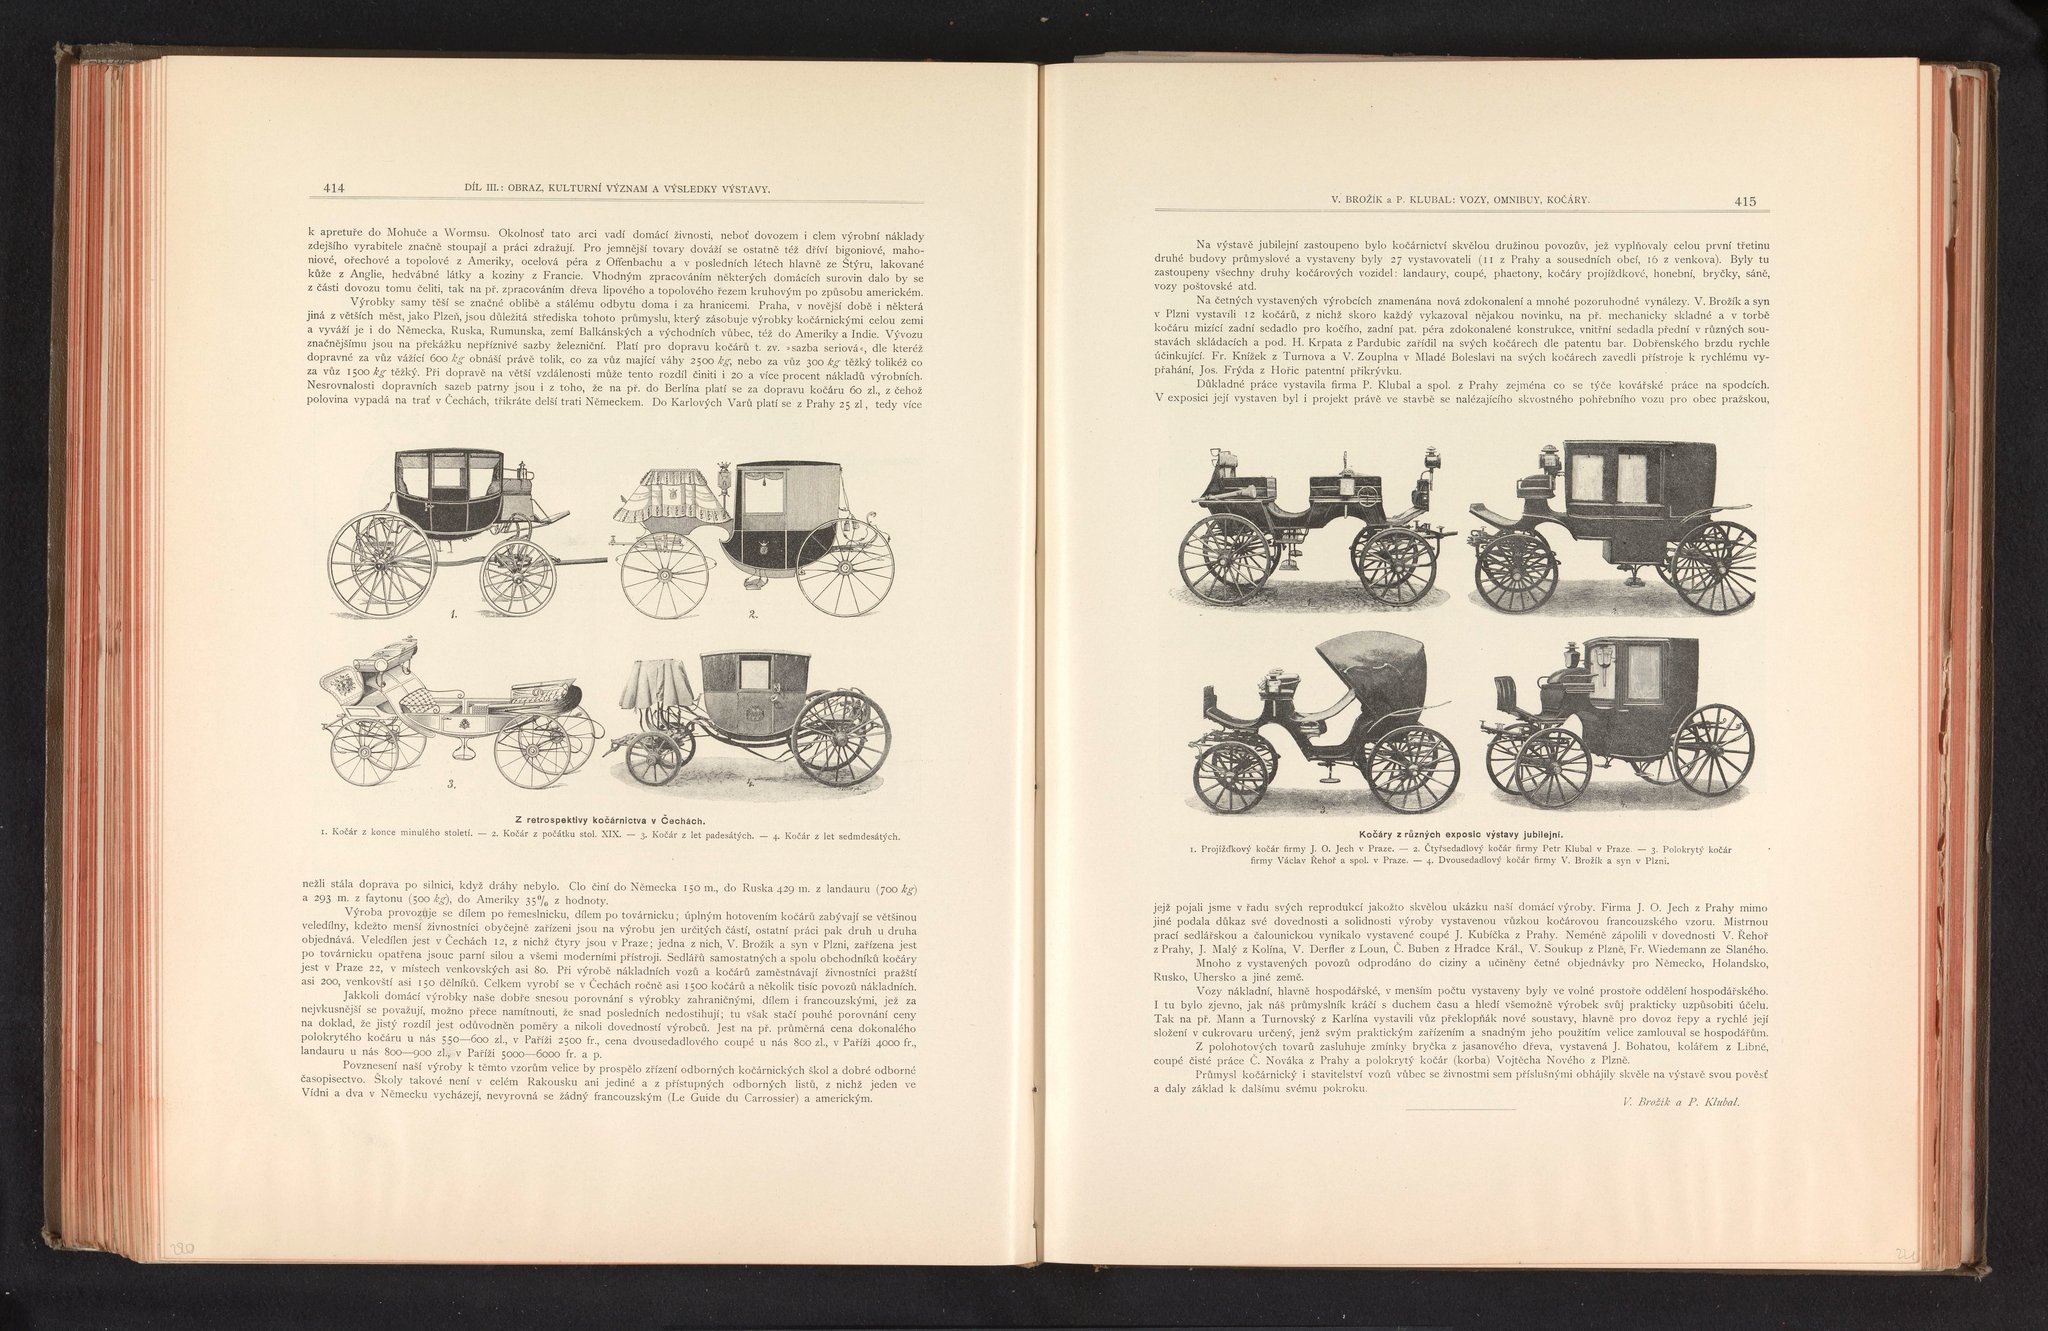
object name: page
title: Vier koetsen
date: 1890-1895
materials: paper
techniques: autotype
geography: prague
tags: four-wheeled, animal-drawn vehicle, e.g.: cab, carriage, coach